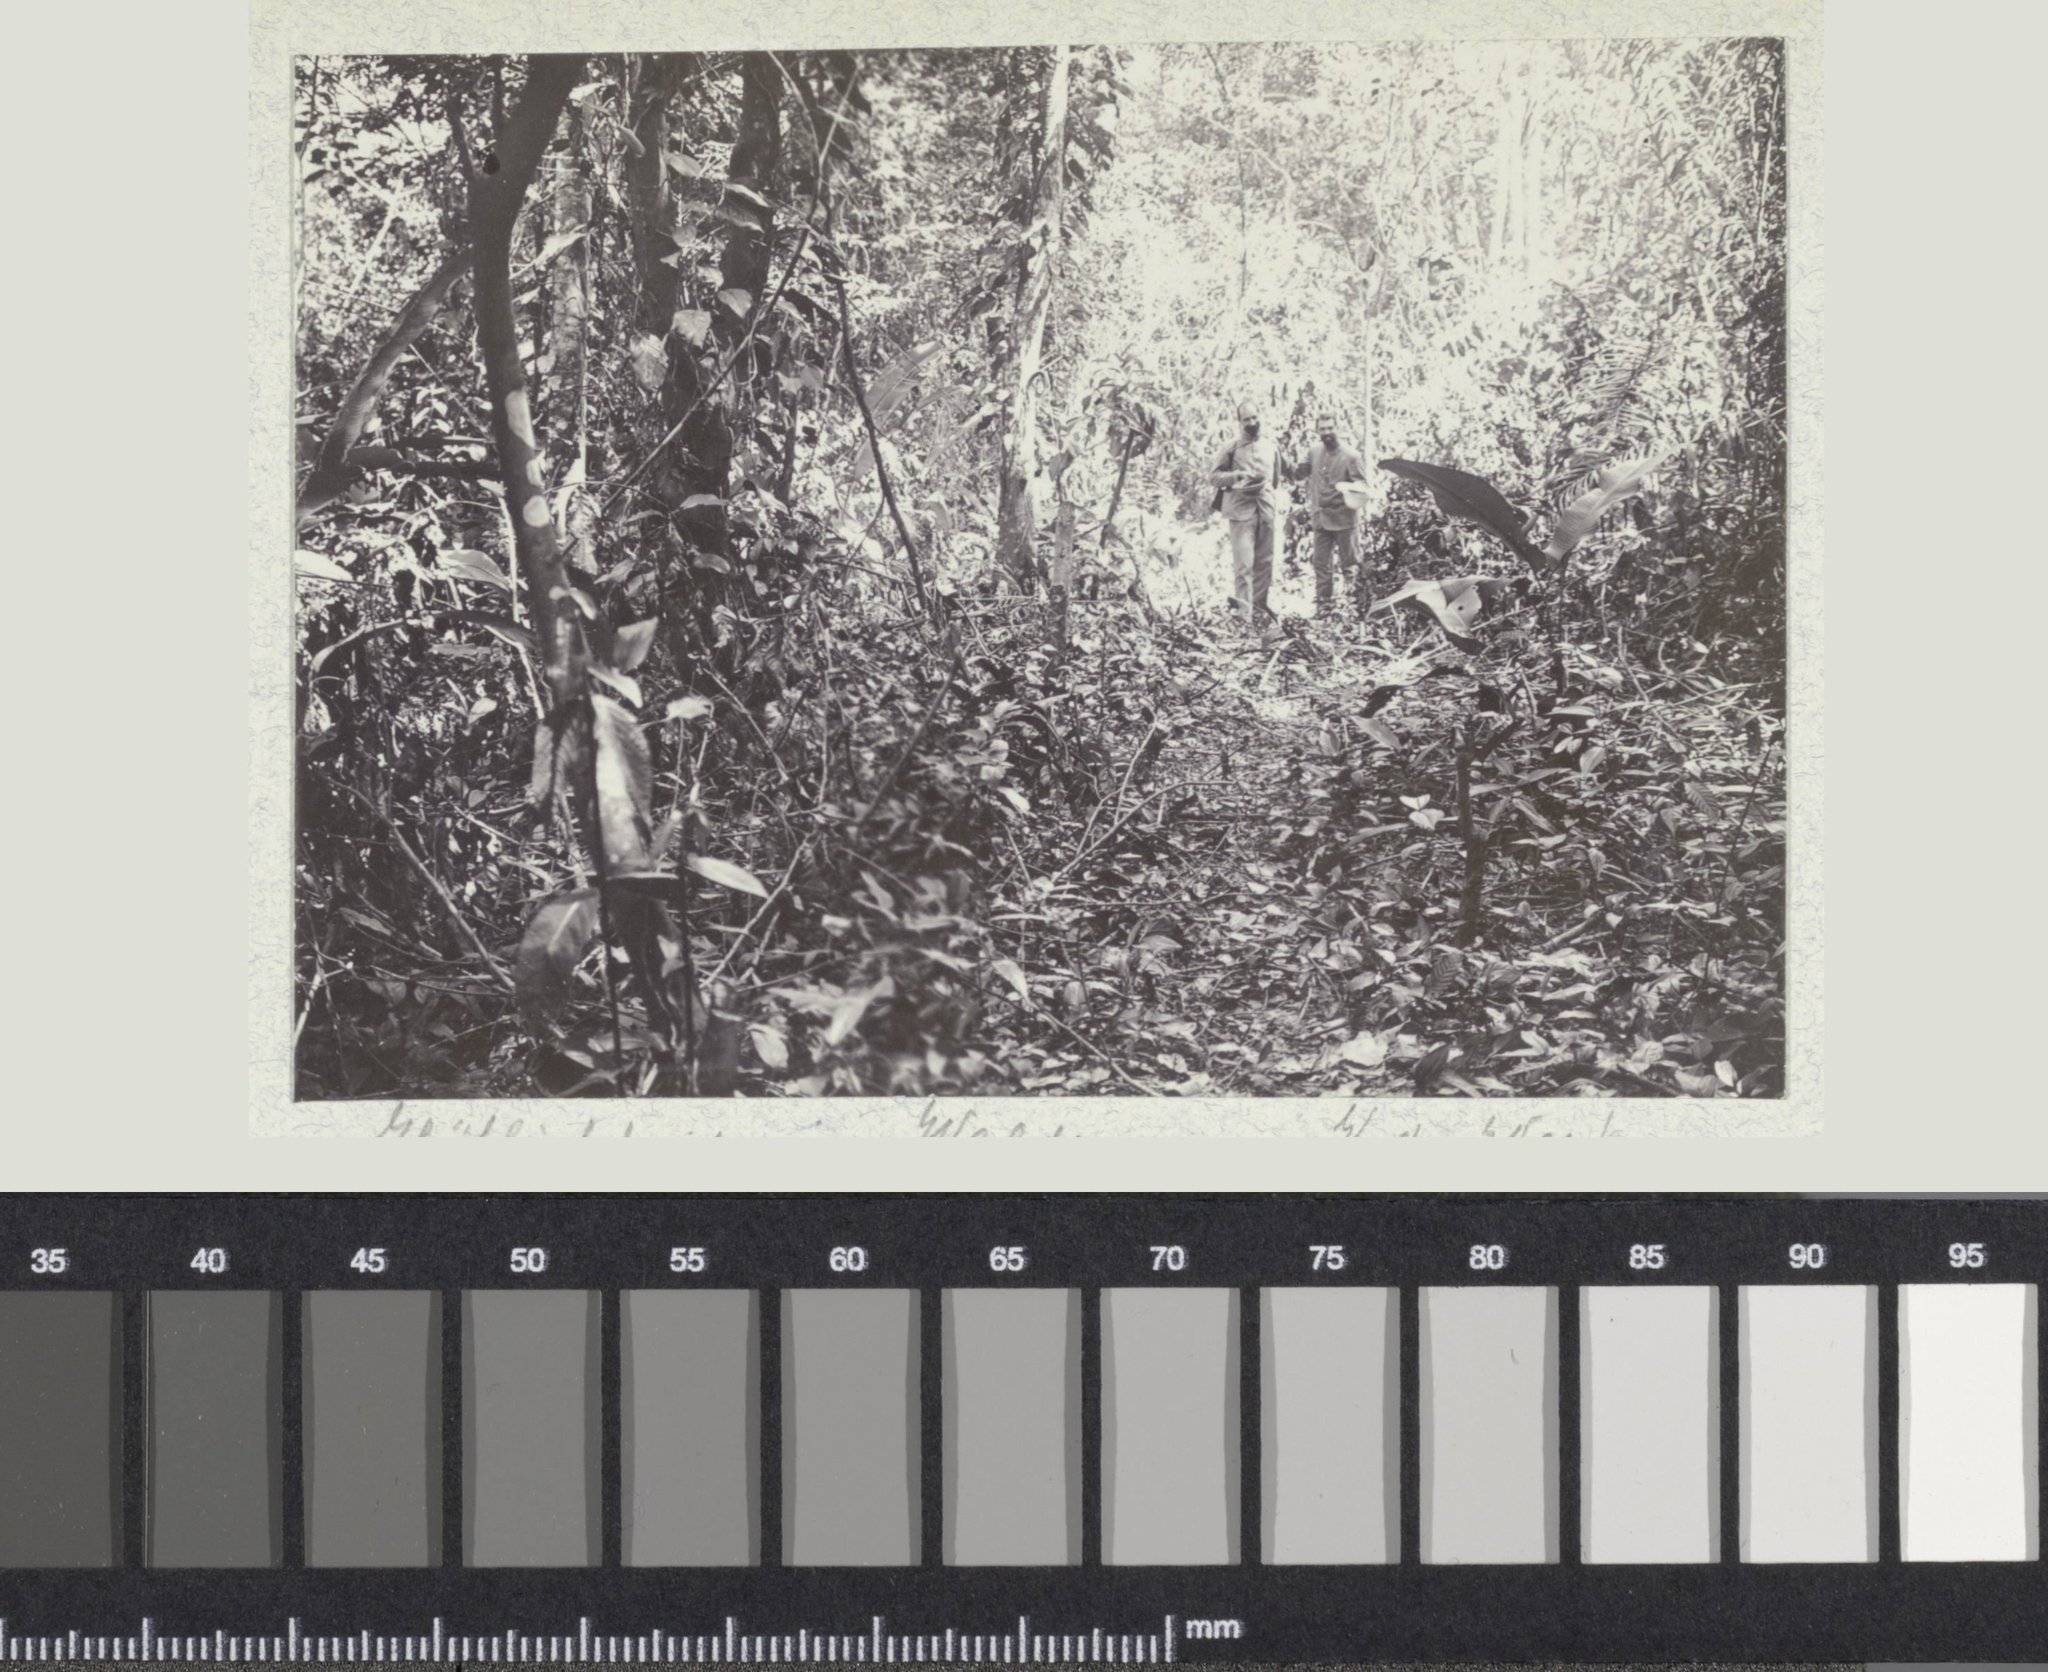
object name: photograph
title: Van de Werk en Van Hall in het woud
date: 1908-1910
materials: photographic support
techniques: photography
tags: jungle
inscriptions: inscription: ‘Höflichkeit im Walde. October 1908 P'bo / V.d Werk / v. Hall’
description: Van de Werk en Van Hall in het woud, zij nemen hun hoed af voor de fotograaf. Oktober 1908, Paramaribo. Onderdeel van het fotoalbum van de familie Boom-Gonggrijp in Suriname en Curaçao.